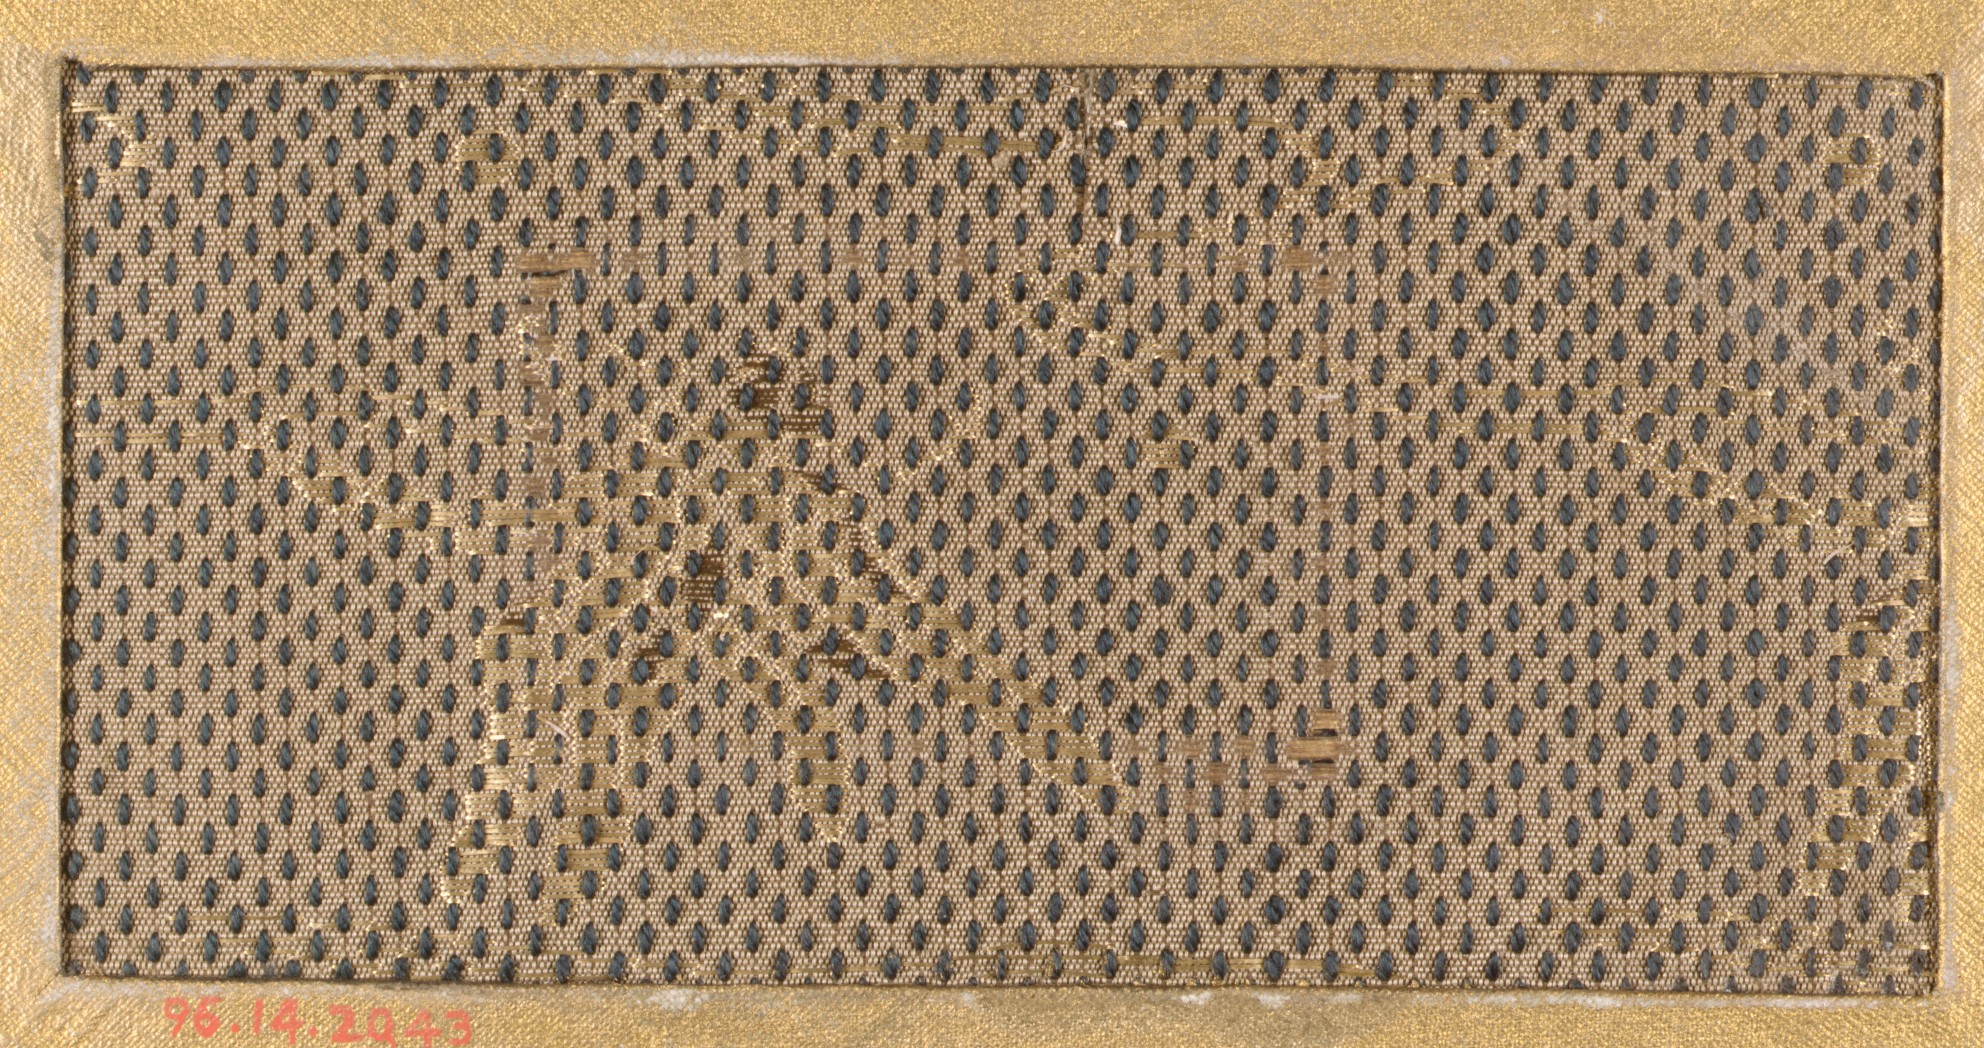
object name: piece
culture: japanese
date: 1701-1900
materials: silk